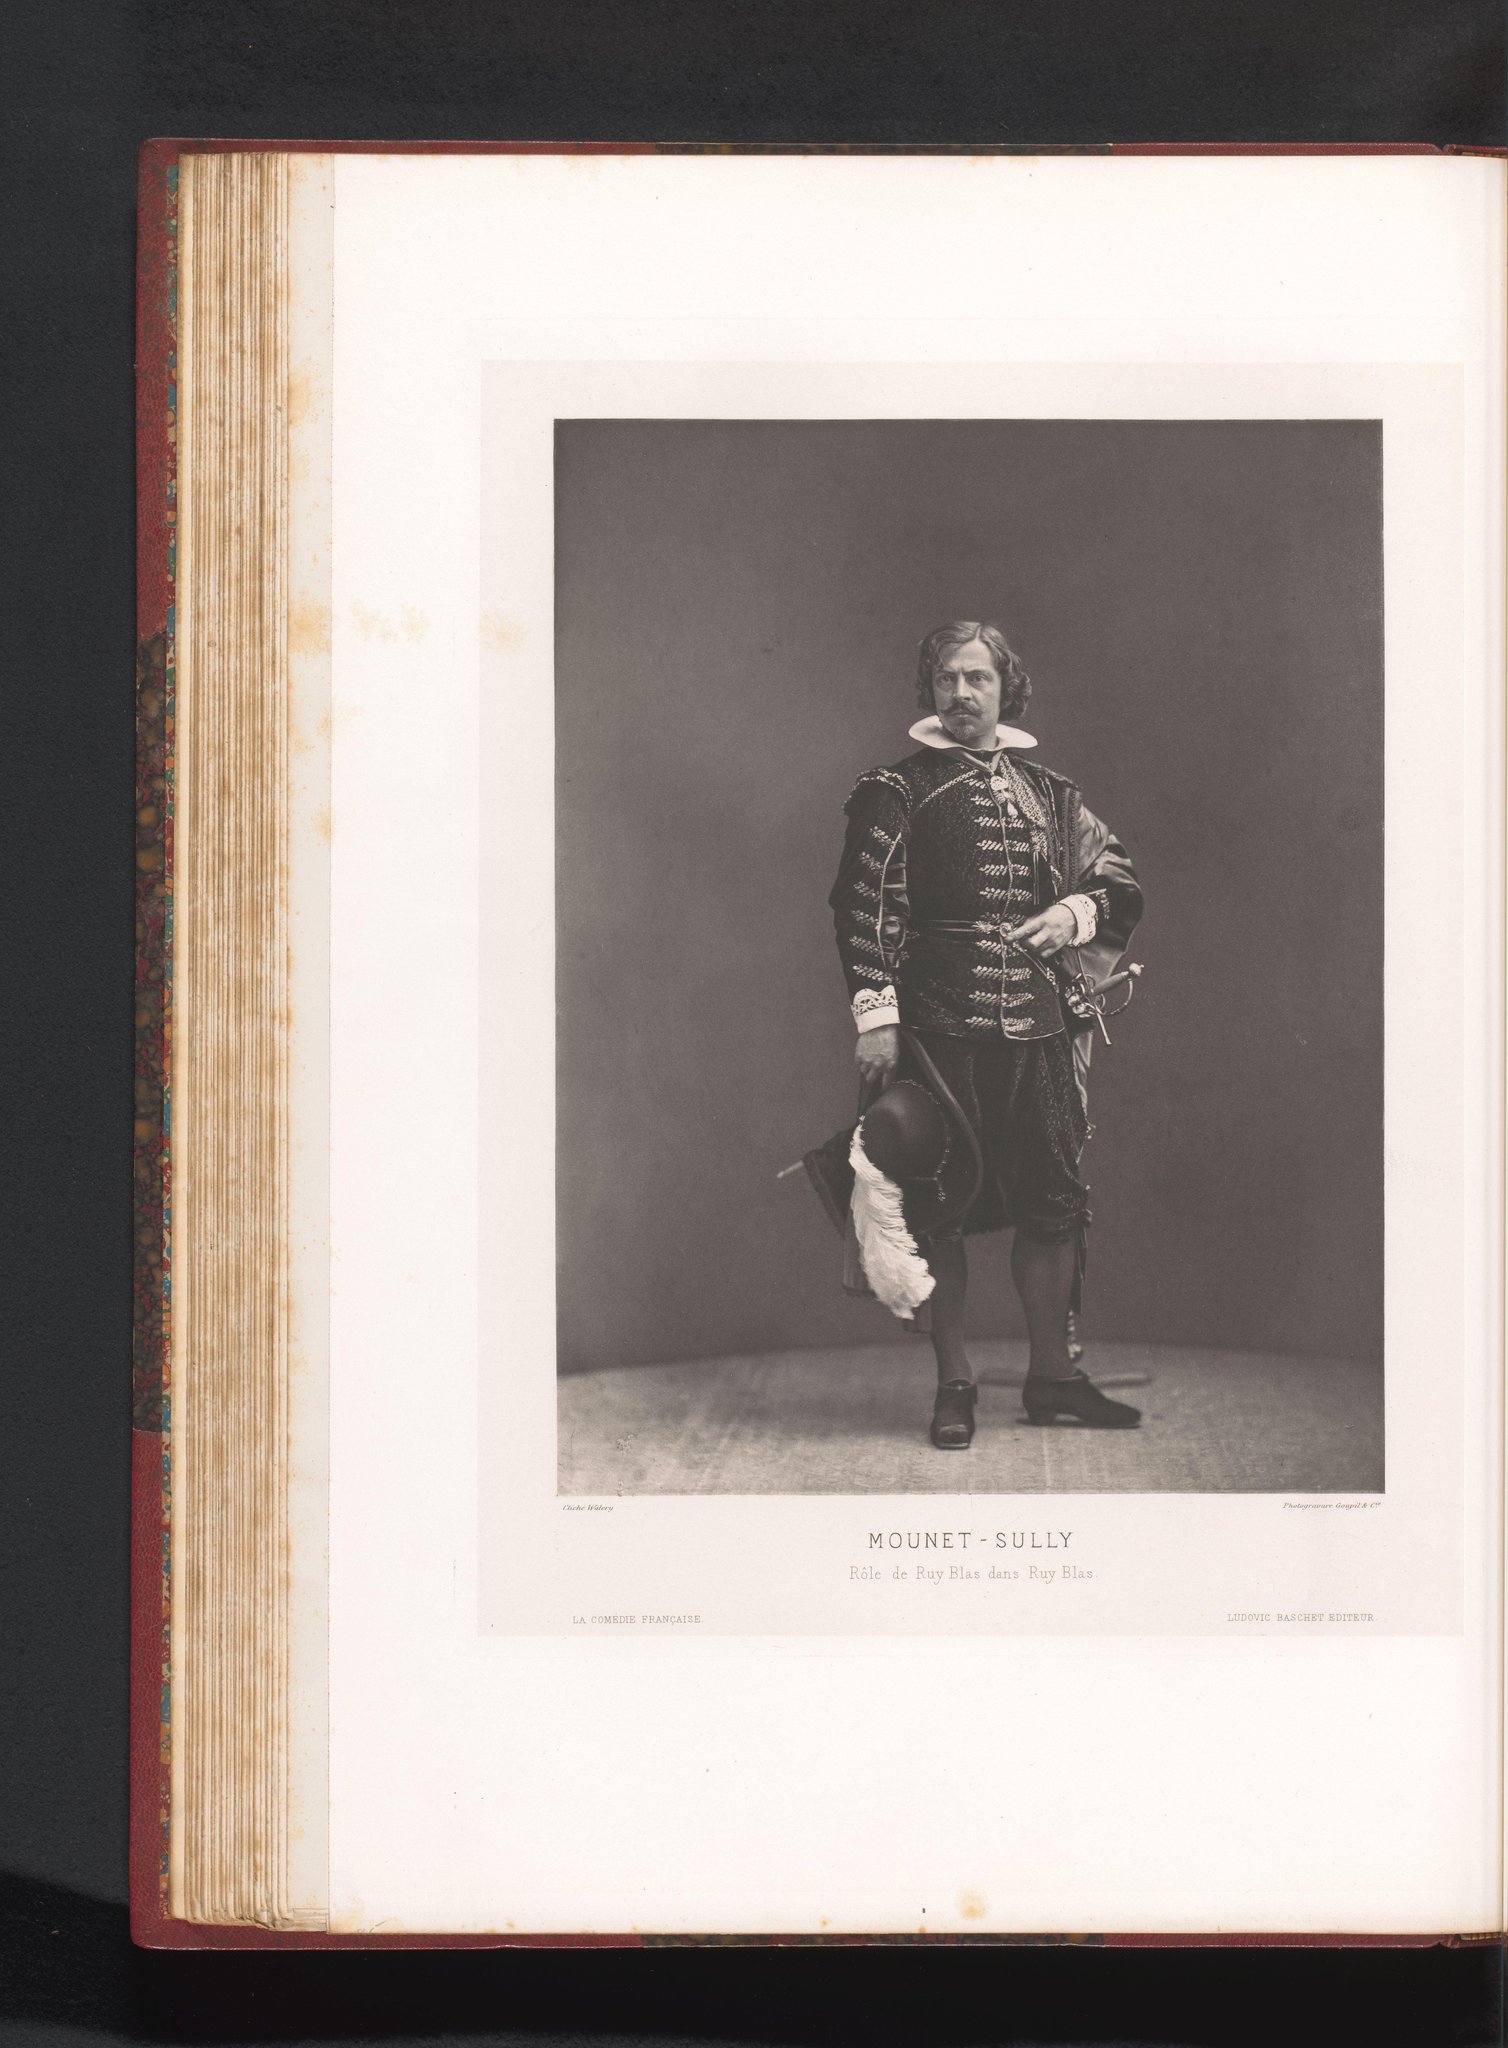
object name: photomechanical print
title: Portret van Jean-Sully Mounet in de rol van Ruy Blas in Ruy Blas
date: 1875-1880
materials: paper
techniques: photoaquatint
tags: paris, historical persons, portrait of actor, actress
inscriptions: inscription: ‘LA COMÉDIE FRANÇAISE’, number: ‘[85]’